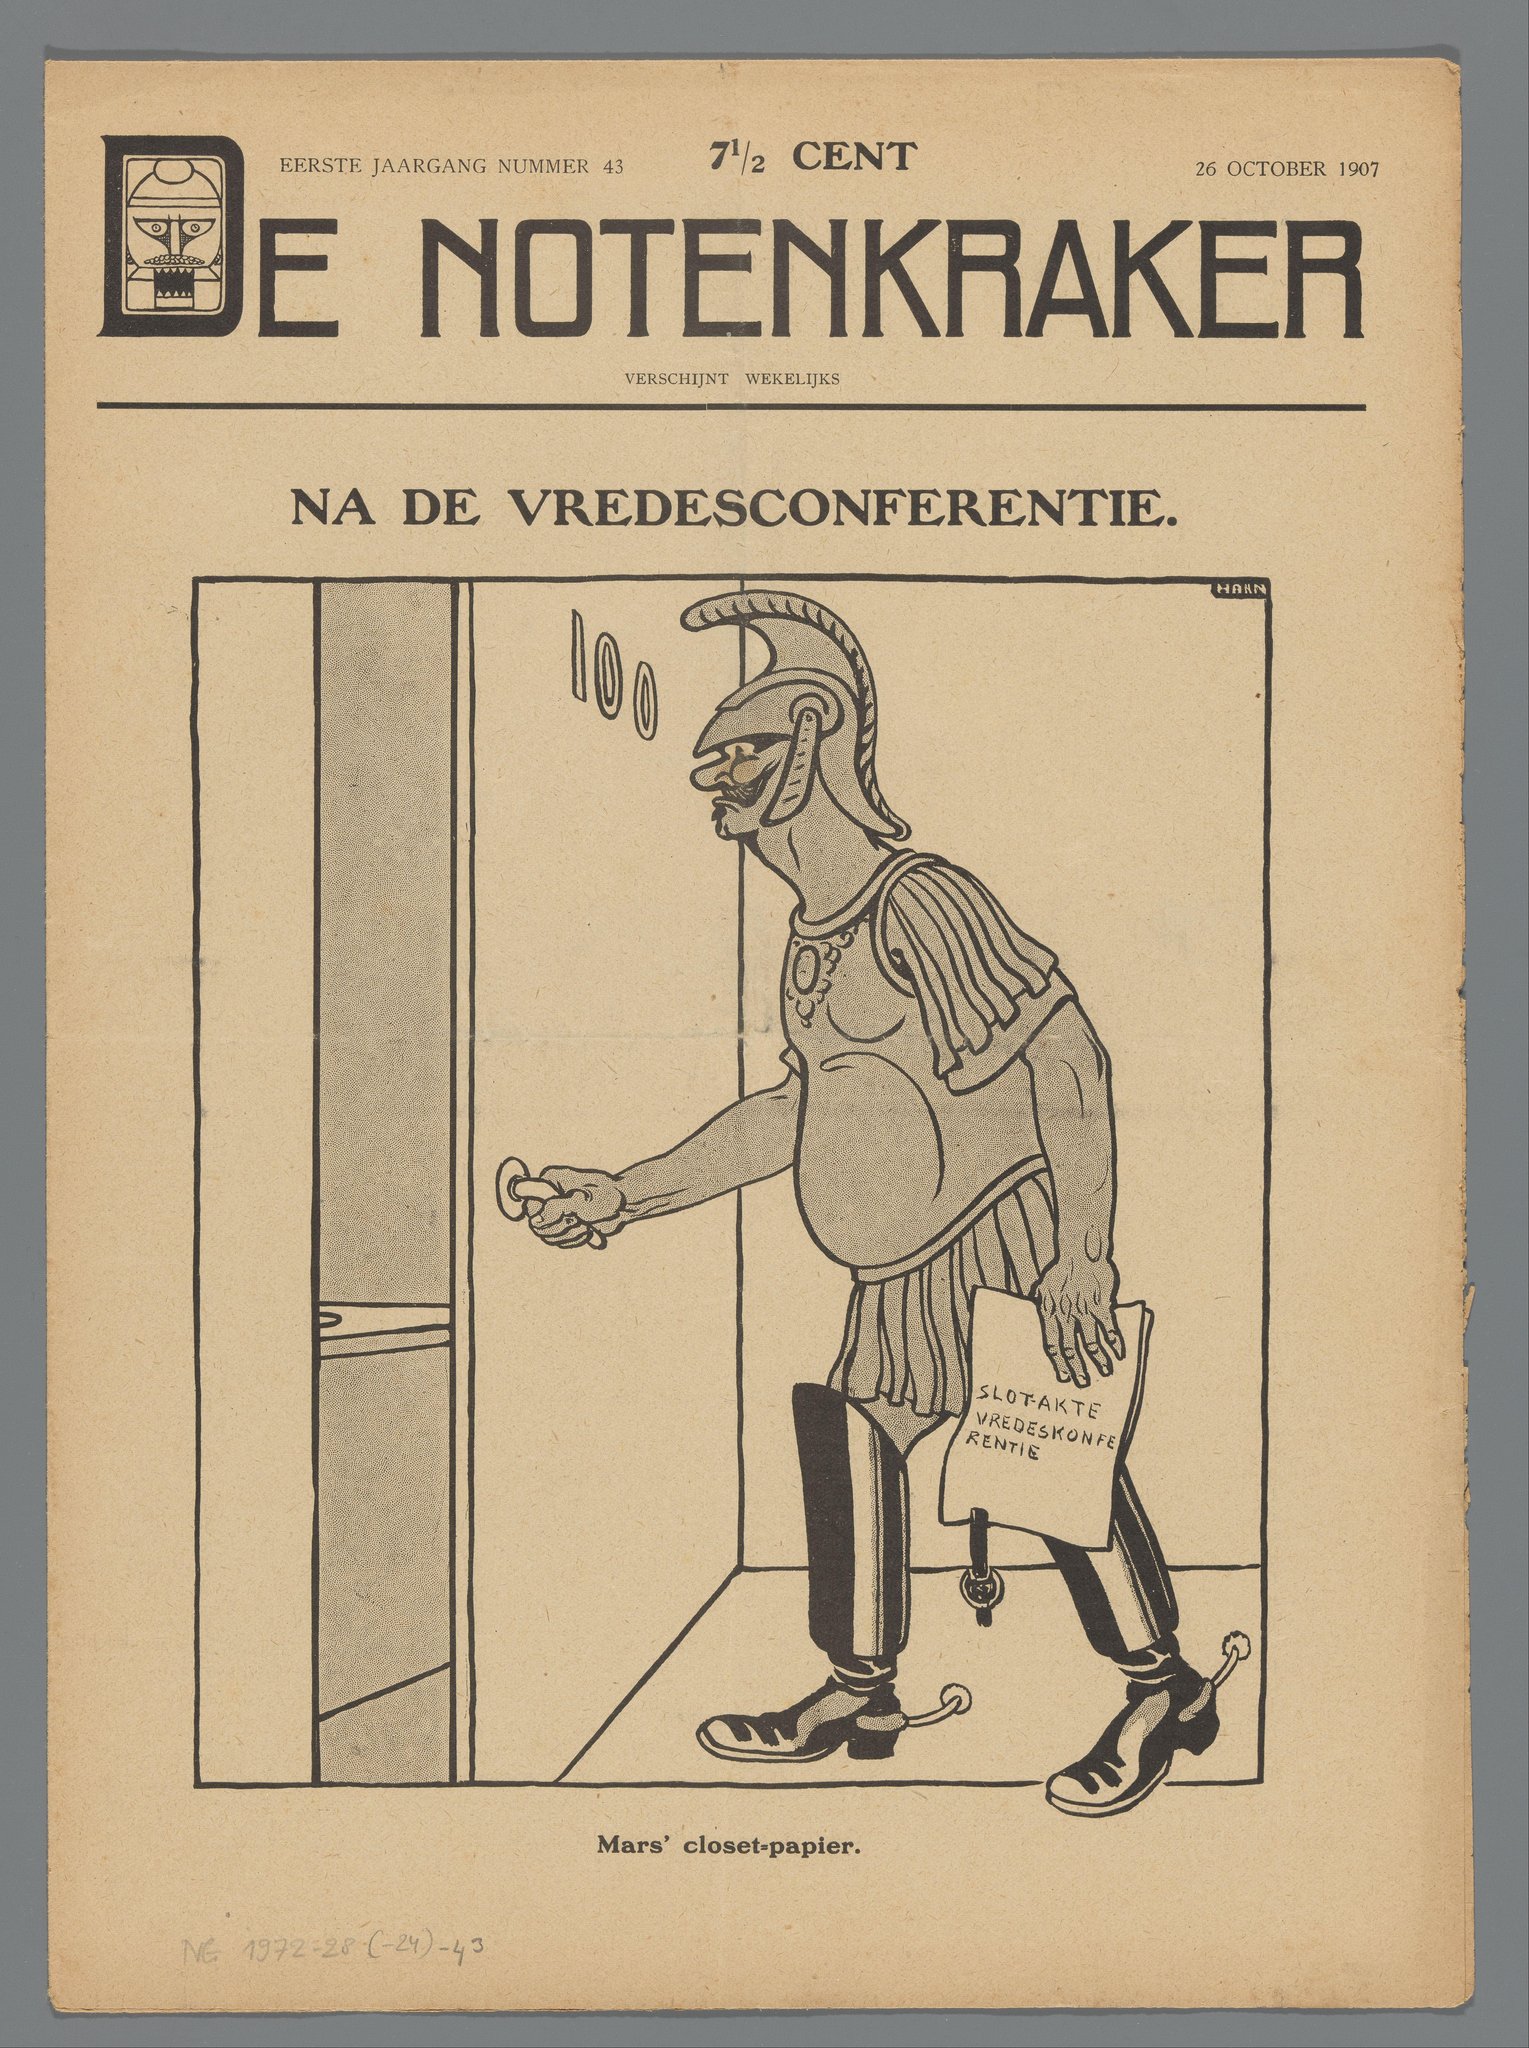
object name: print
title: De Notenkraker, 26 oktober 1907 / Na de vredesconferentie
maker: albert hahn (i)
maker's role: draughtsman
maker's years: 1877-1918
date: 1907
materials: paper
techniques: lithograph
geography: netherlands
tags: lavatory, water-closet, symbols, allegories of war; 'guerra' (ripa), signing of peace treaty, concluding the peace, defecation, political caricatures and satires, netherlands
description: Aflevering van het satirische tijdschrift De Notenkraker van 26 oktober 1907, eerste jaargang, nummer 43. Omslag met illustratie van de oorlogsgod Mars die naar de WC gaat met het vredesakkoord in de hand als toiletpapier. Onderdeel van een volledige eerste jaargang (1907). Elk nummer bevat 8 bladzijden, deels nog niet losgesneden, met op de voorzijde steeds een spotprent van Albert Hahn, op de overige pagina's prenten van Hahn steeds tussen de tekst. In de letter 'D' van de titel is een kop van een zgn. notenkraker afgebeeld.